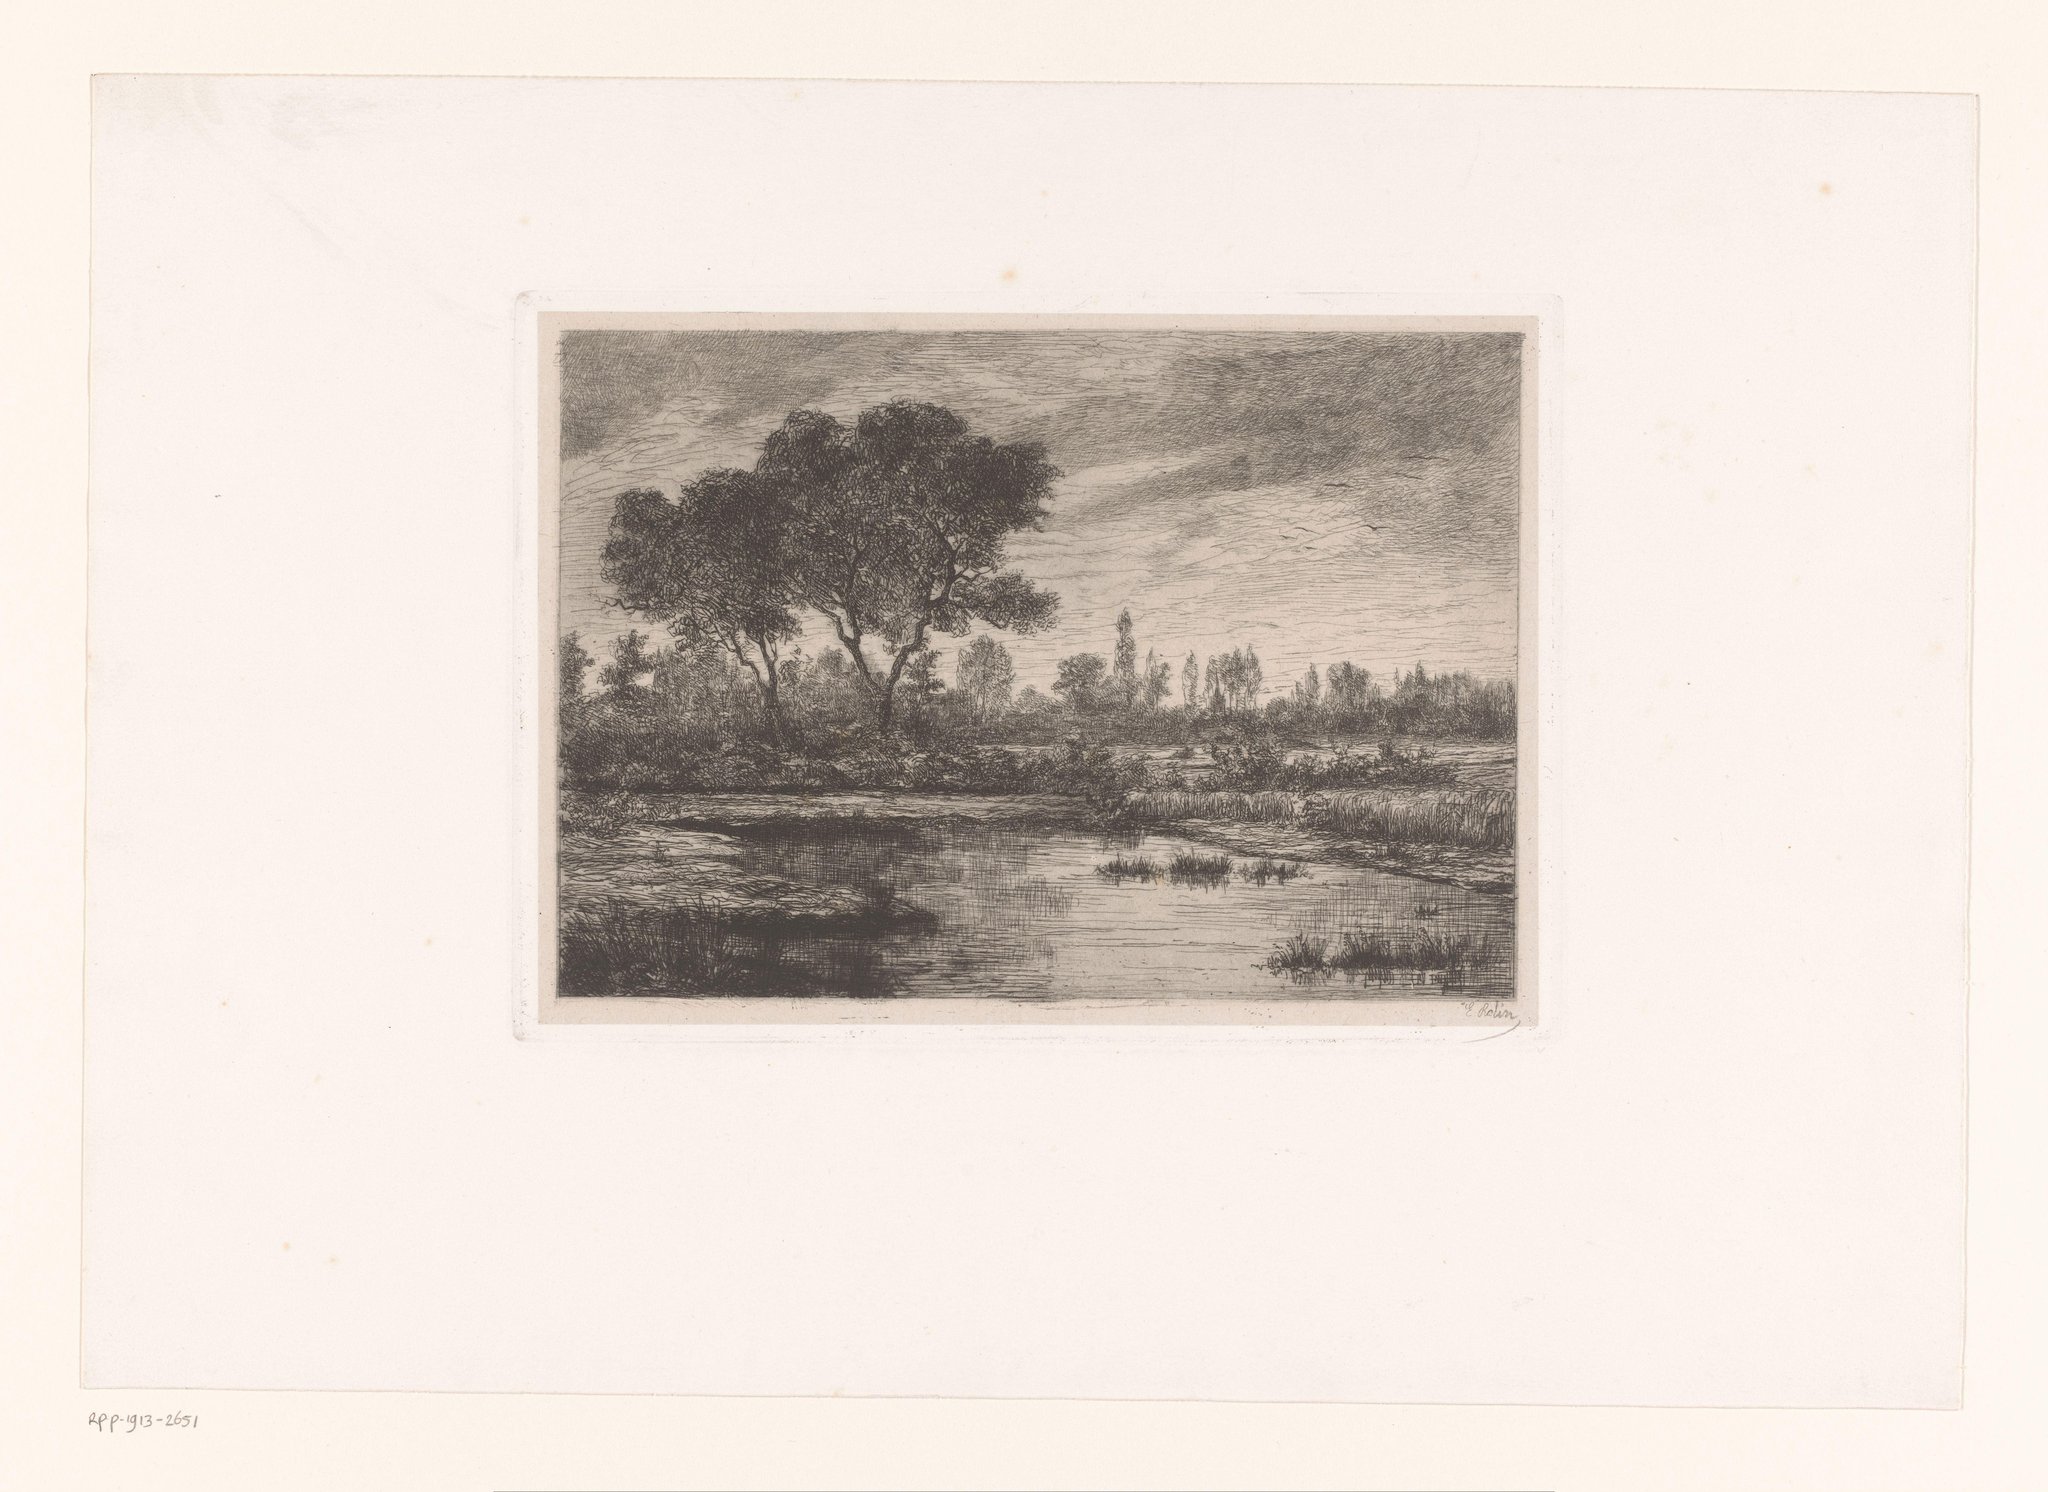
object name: print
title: Veenlandschap bij Hoogstraten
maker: emilie rolin-jacquemijns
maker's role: print maker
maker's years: 1842-1906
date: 1852-1906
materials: paper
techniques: etching, intaglio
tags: swamp, inland marsh, fens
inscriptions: collector's mark: Lugt 2228